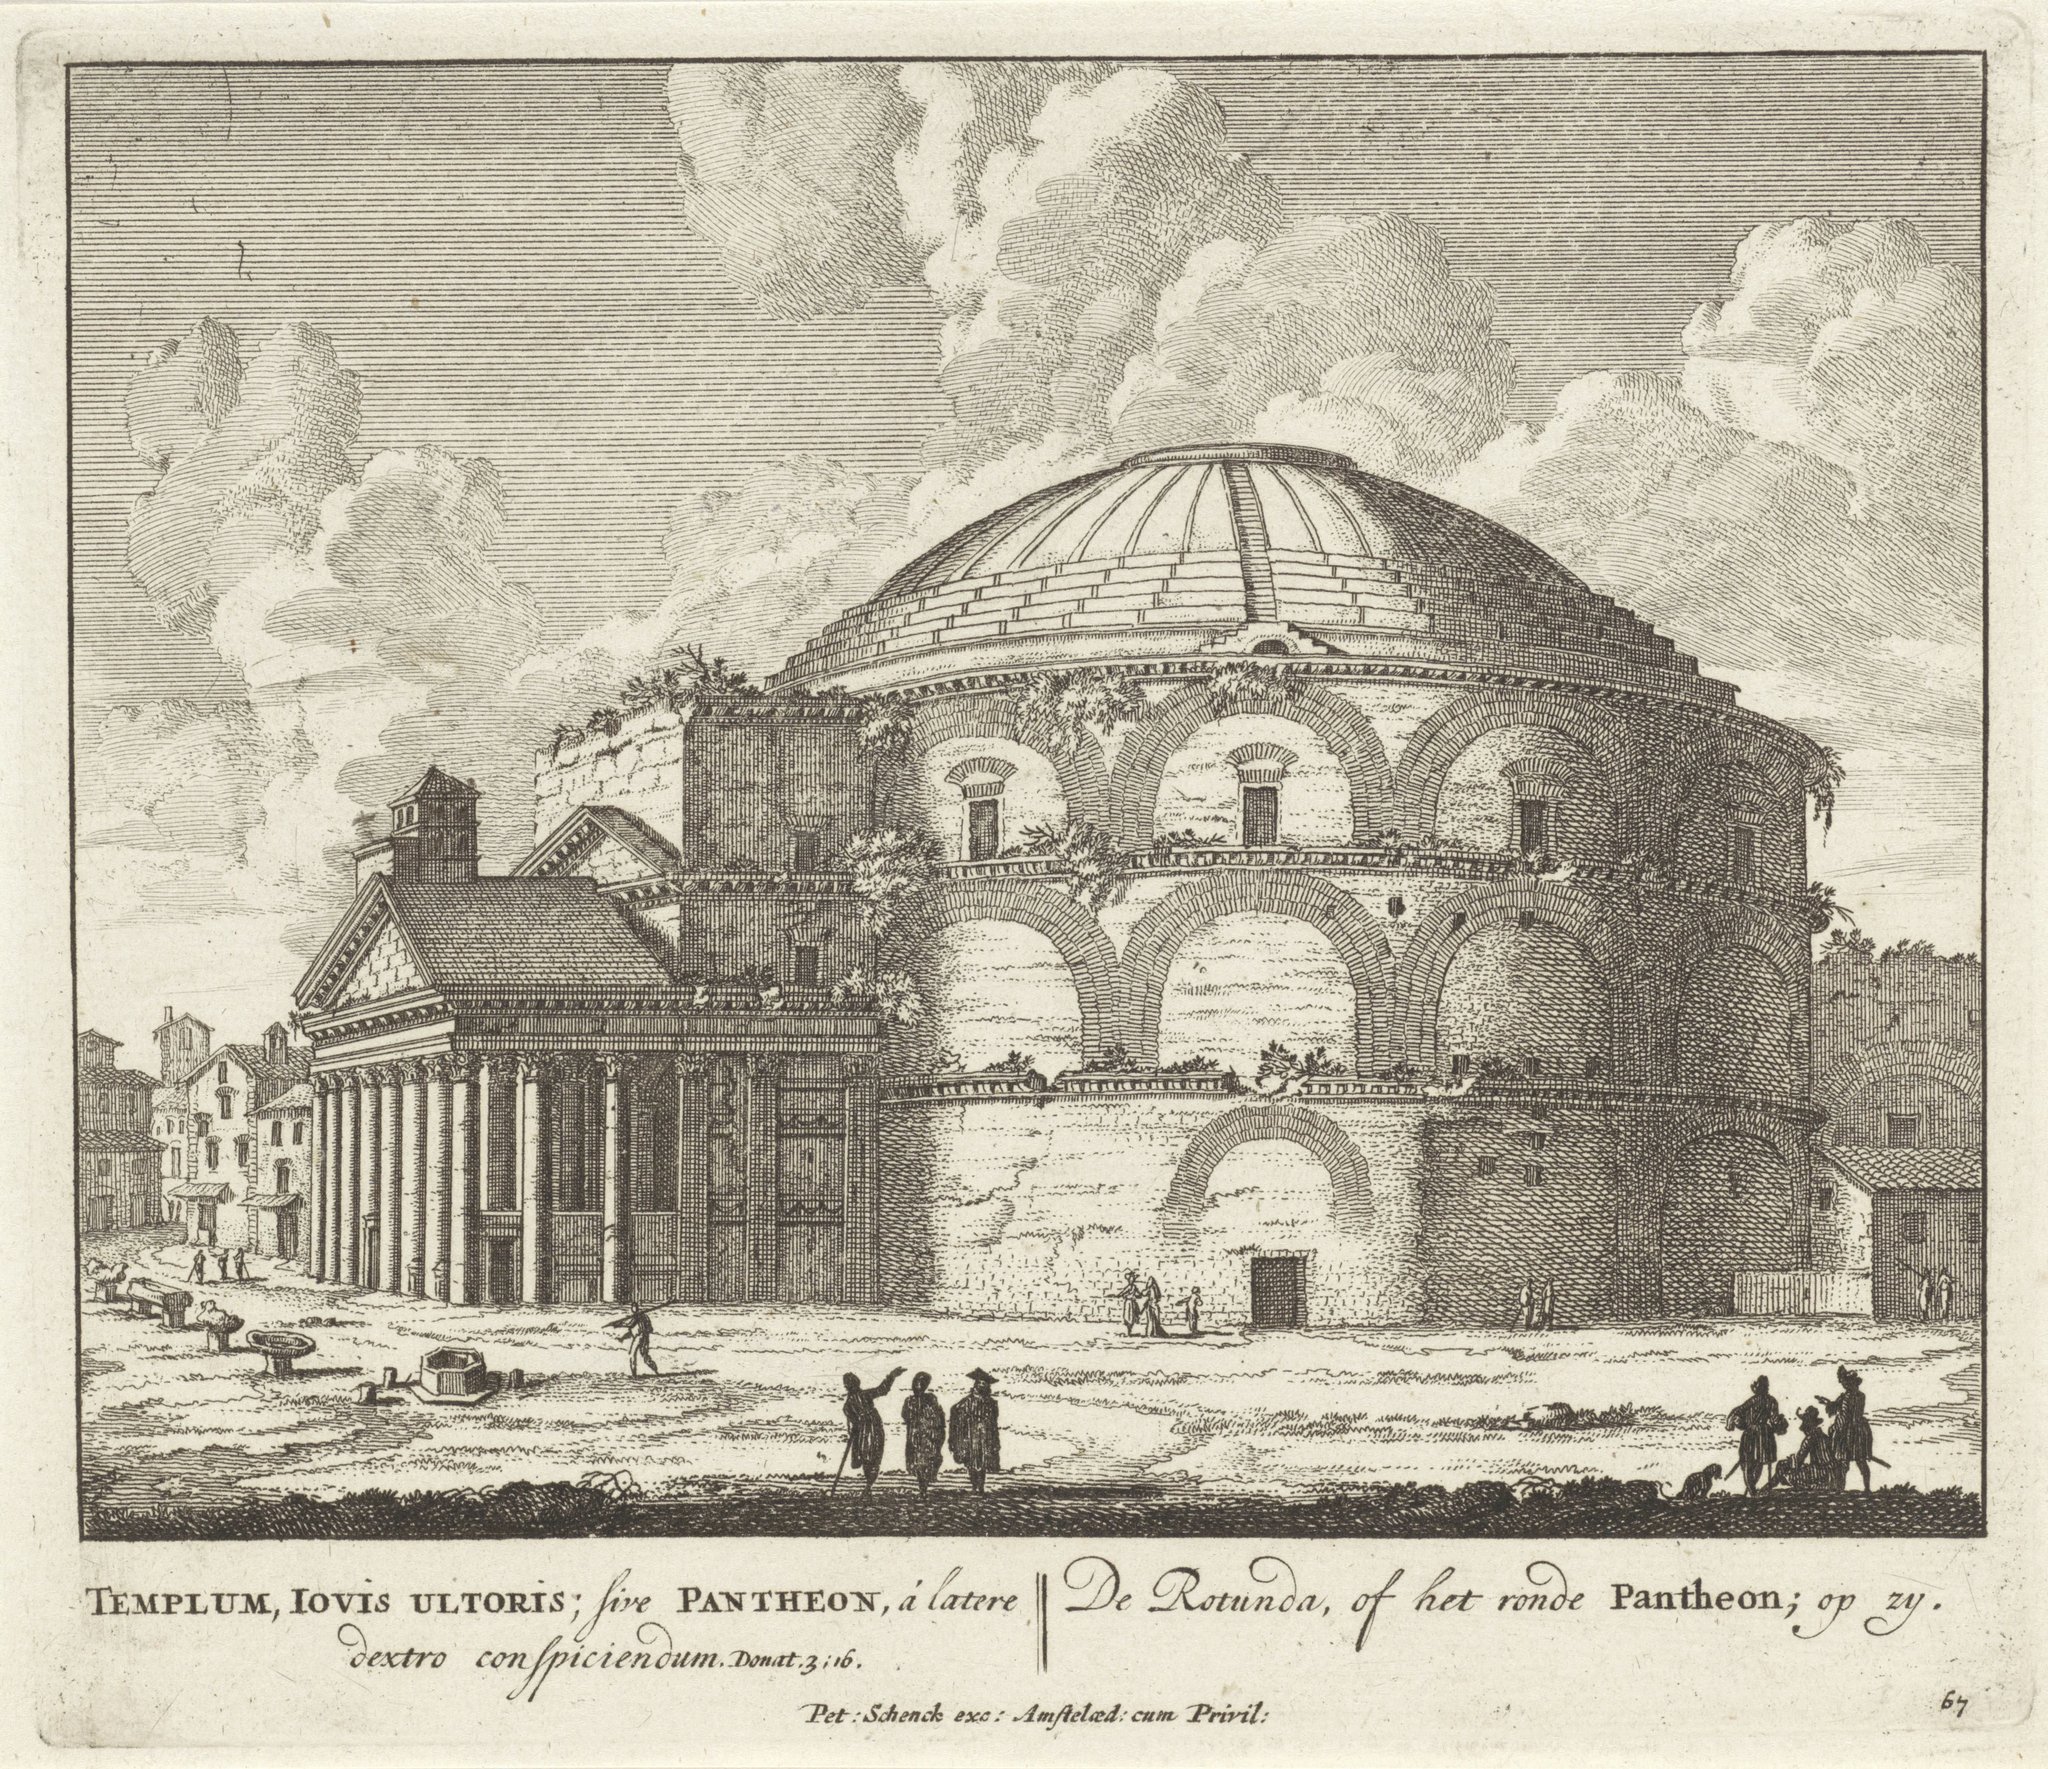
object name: print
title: Gezicht op de zijkant van het Pantheon te Rome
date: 1675-1711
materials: paper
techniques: etching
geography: amsterdam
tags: pantheon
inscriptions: collector's mark: Lugt 2228